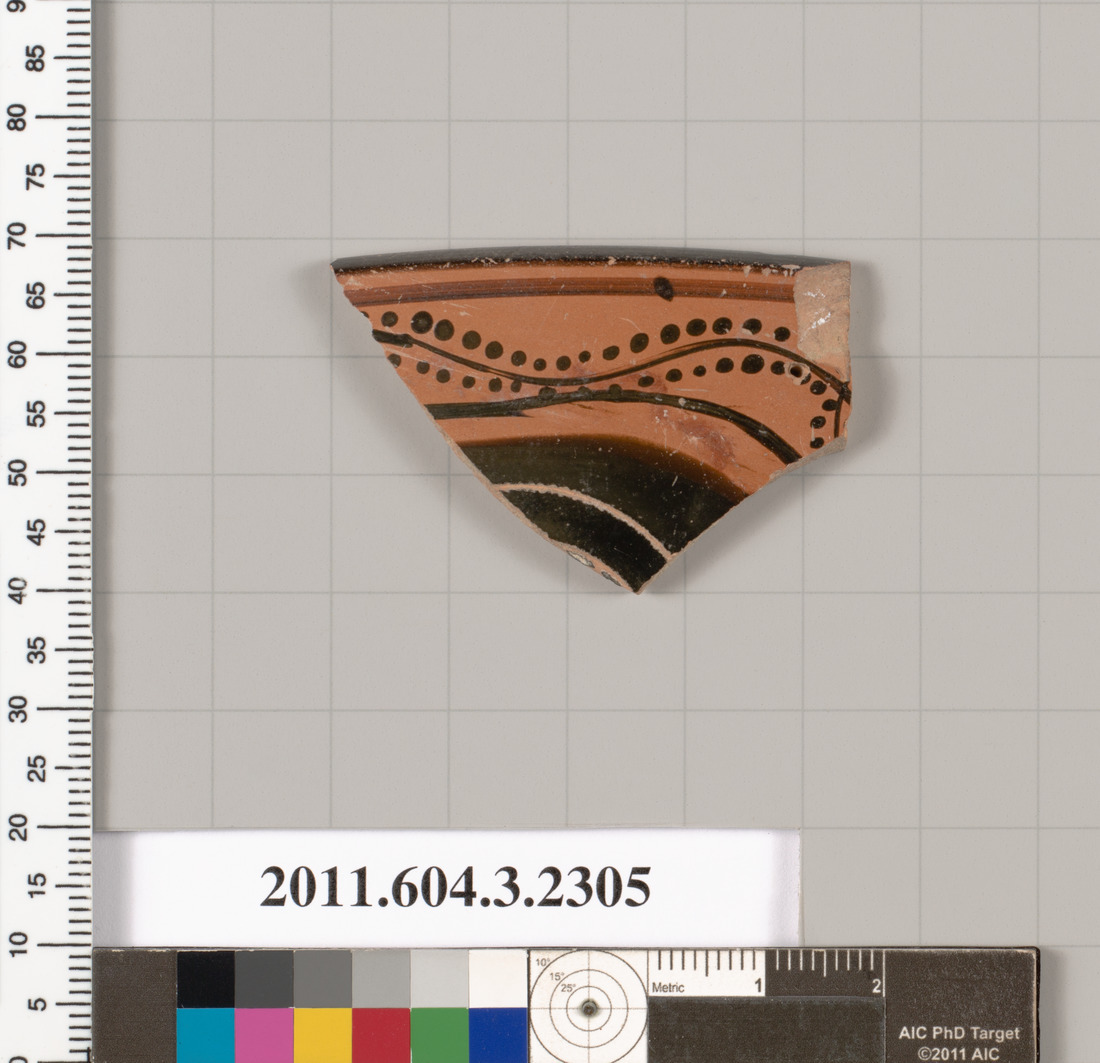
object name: kylix fragment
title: Terracotta rim fragment of a kylix: eye-cup (drinking cup)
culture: greek, attic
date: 530-510 BCE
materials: terracotta